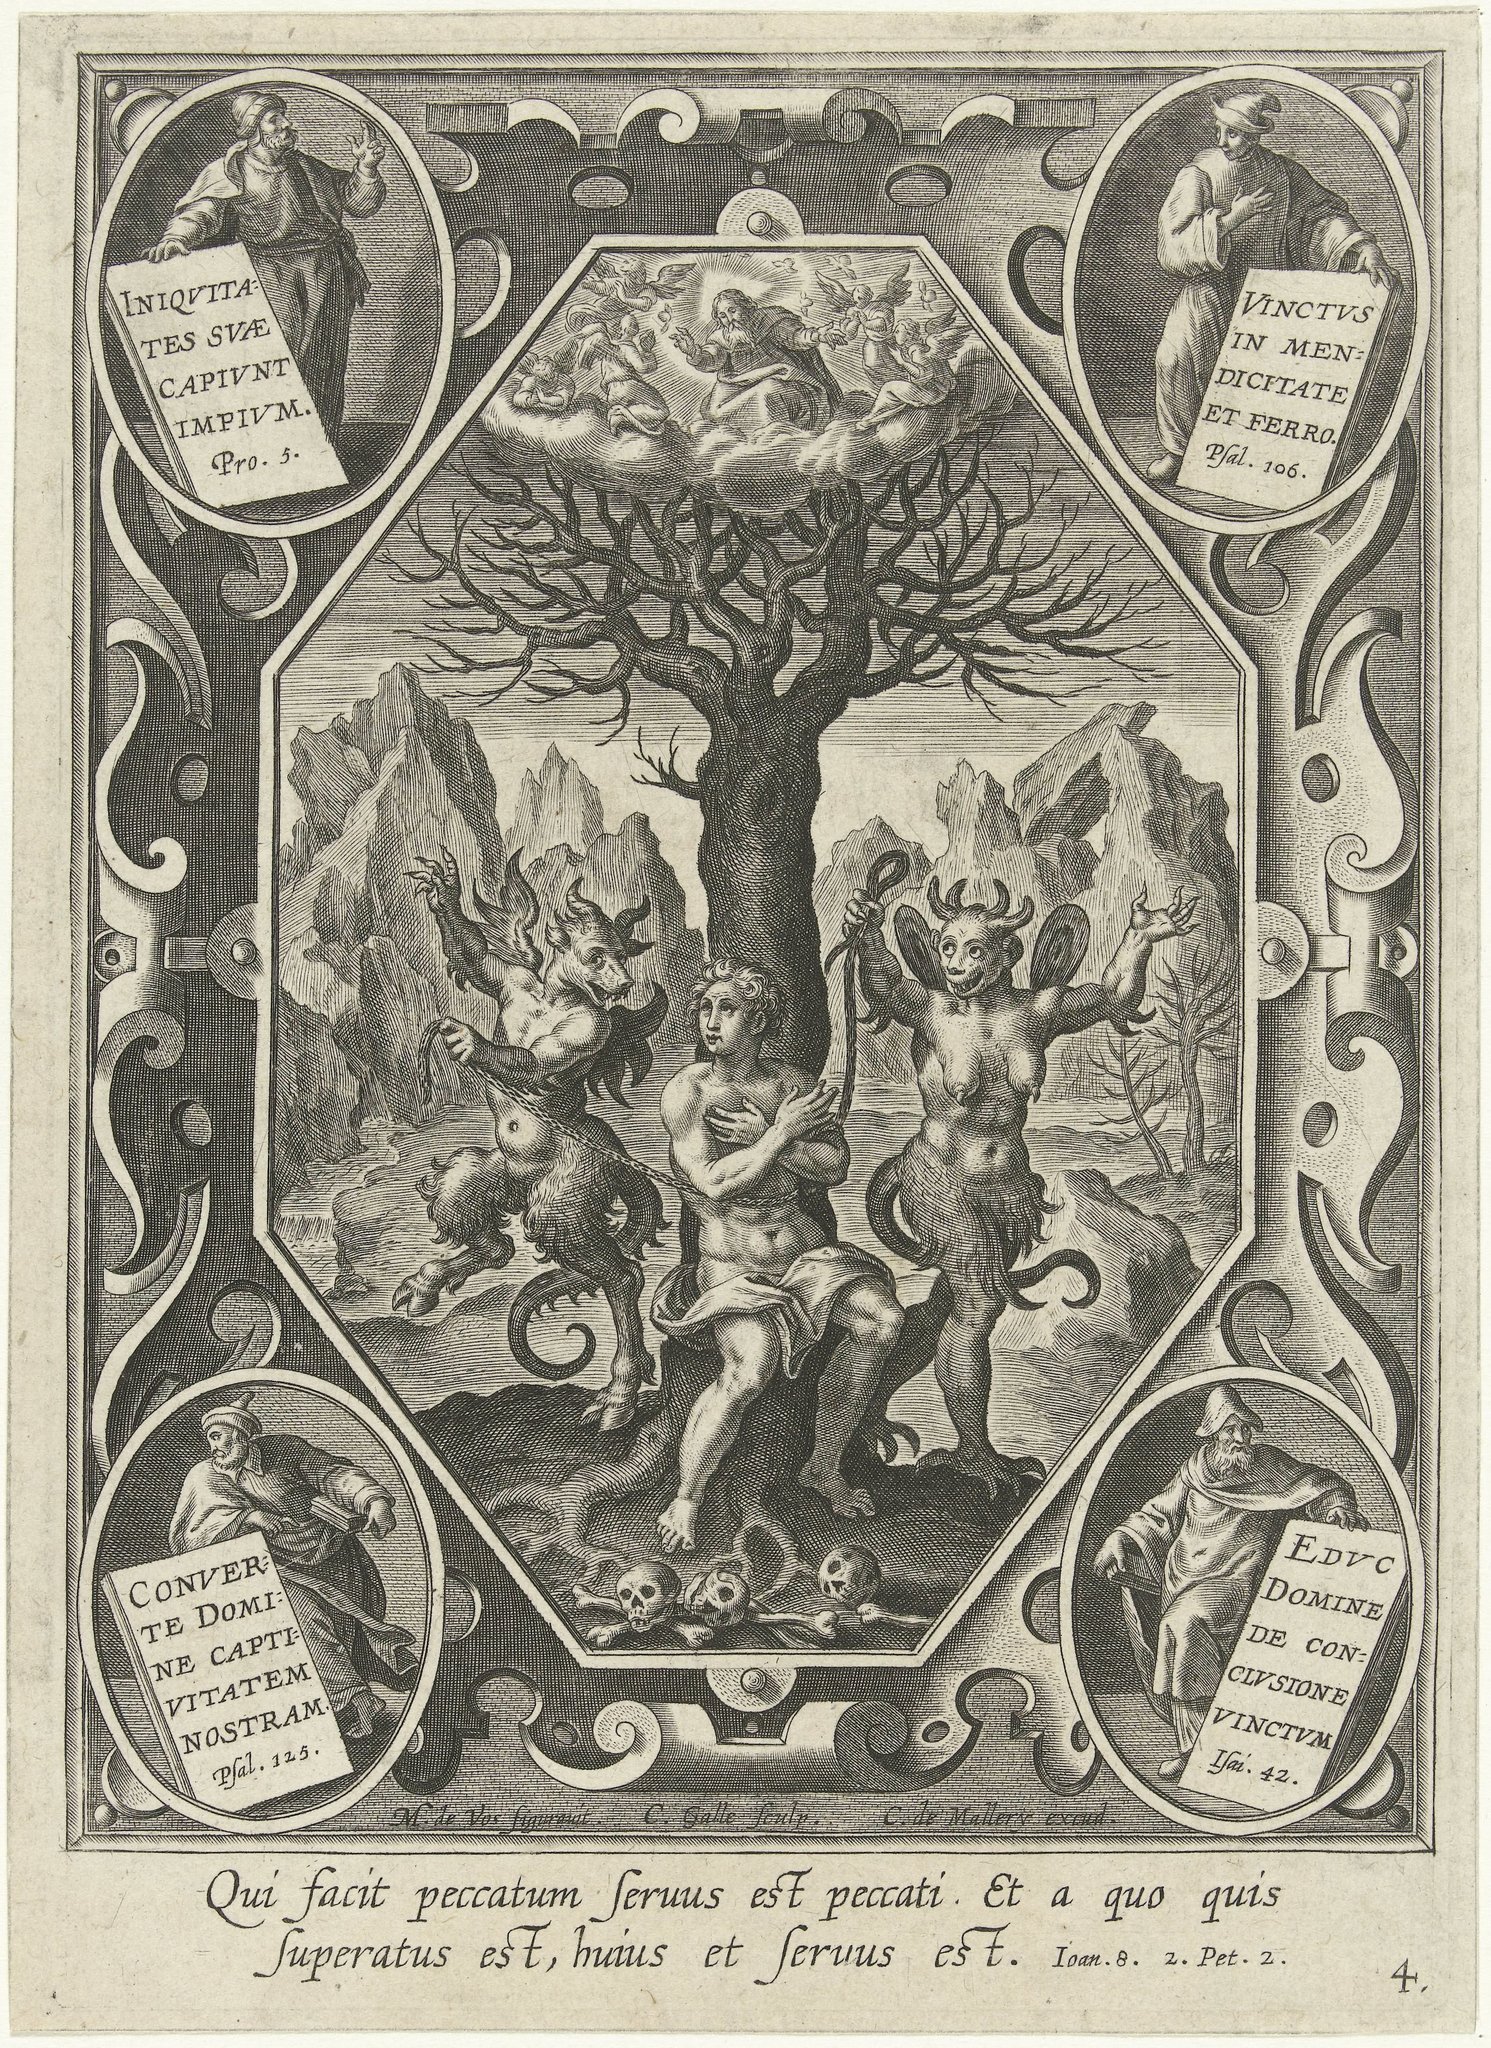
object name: print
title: Zonden en boetedoening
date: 1610-1635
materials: paper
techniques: engraving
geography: southern netherlands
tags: devil or demons attacking mortals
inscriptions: collector's mark: Lugt 2228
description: Een jonge man, gekleed met een doek, wordt door een mannelijke en een vrouwelijke duivel met een touw aan een boom vastgebonden. Op de achtergrond een rotslandschap. Aan de voeten van de man drie schedels met botten.